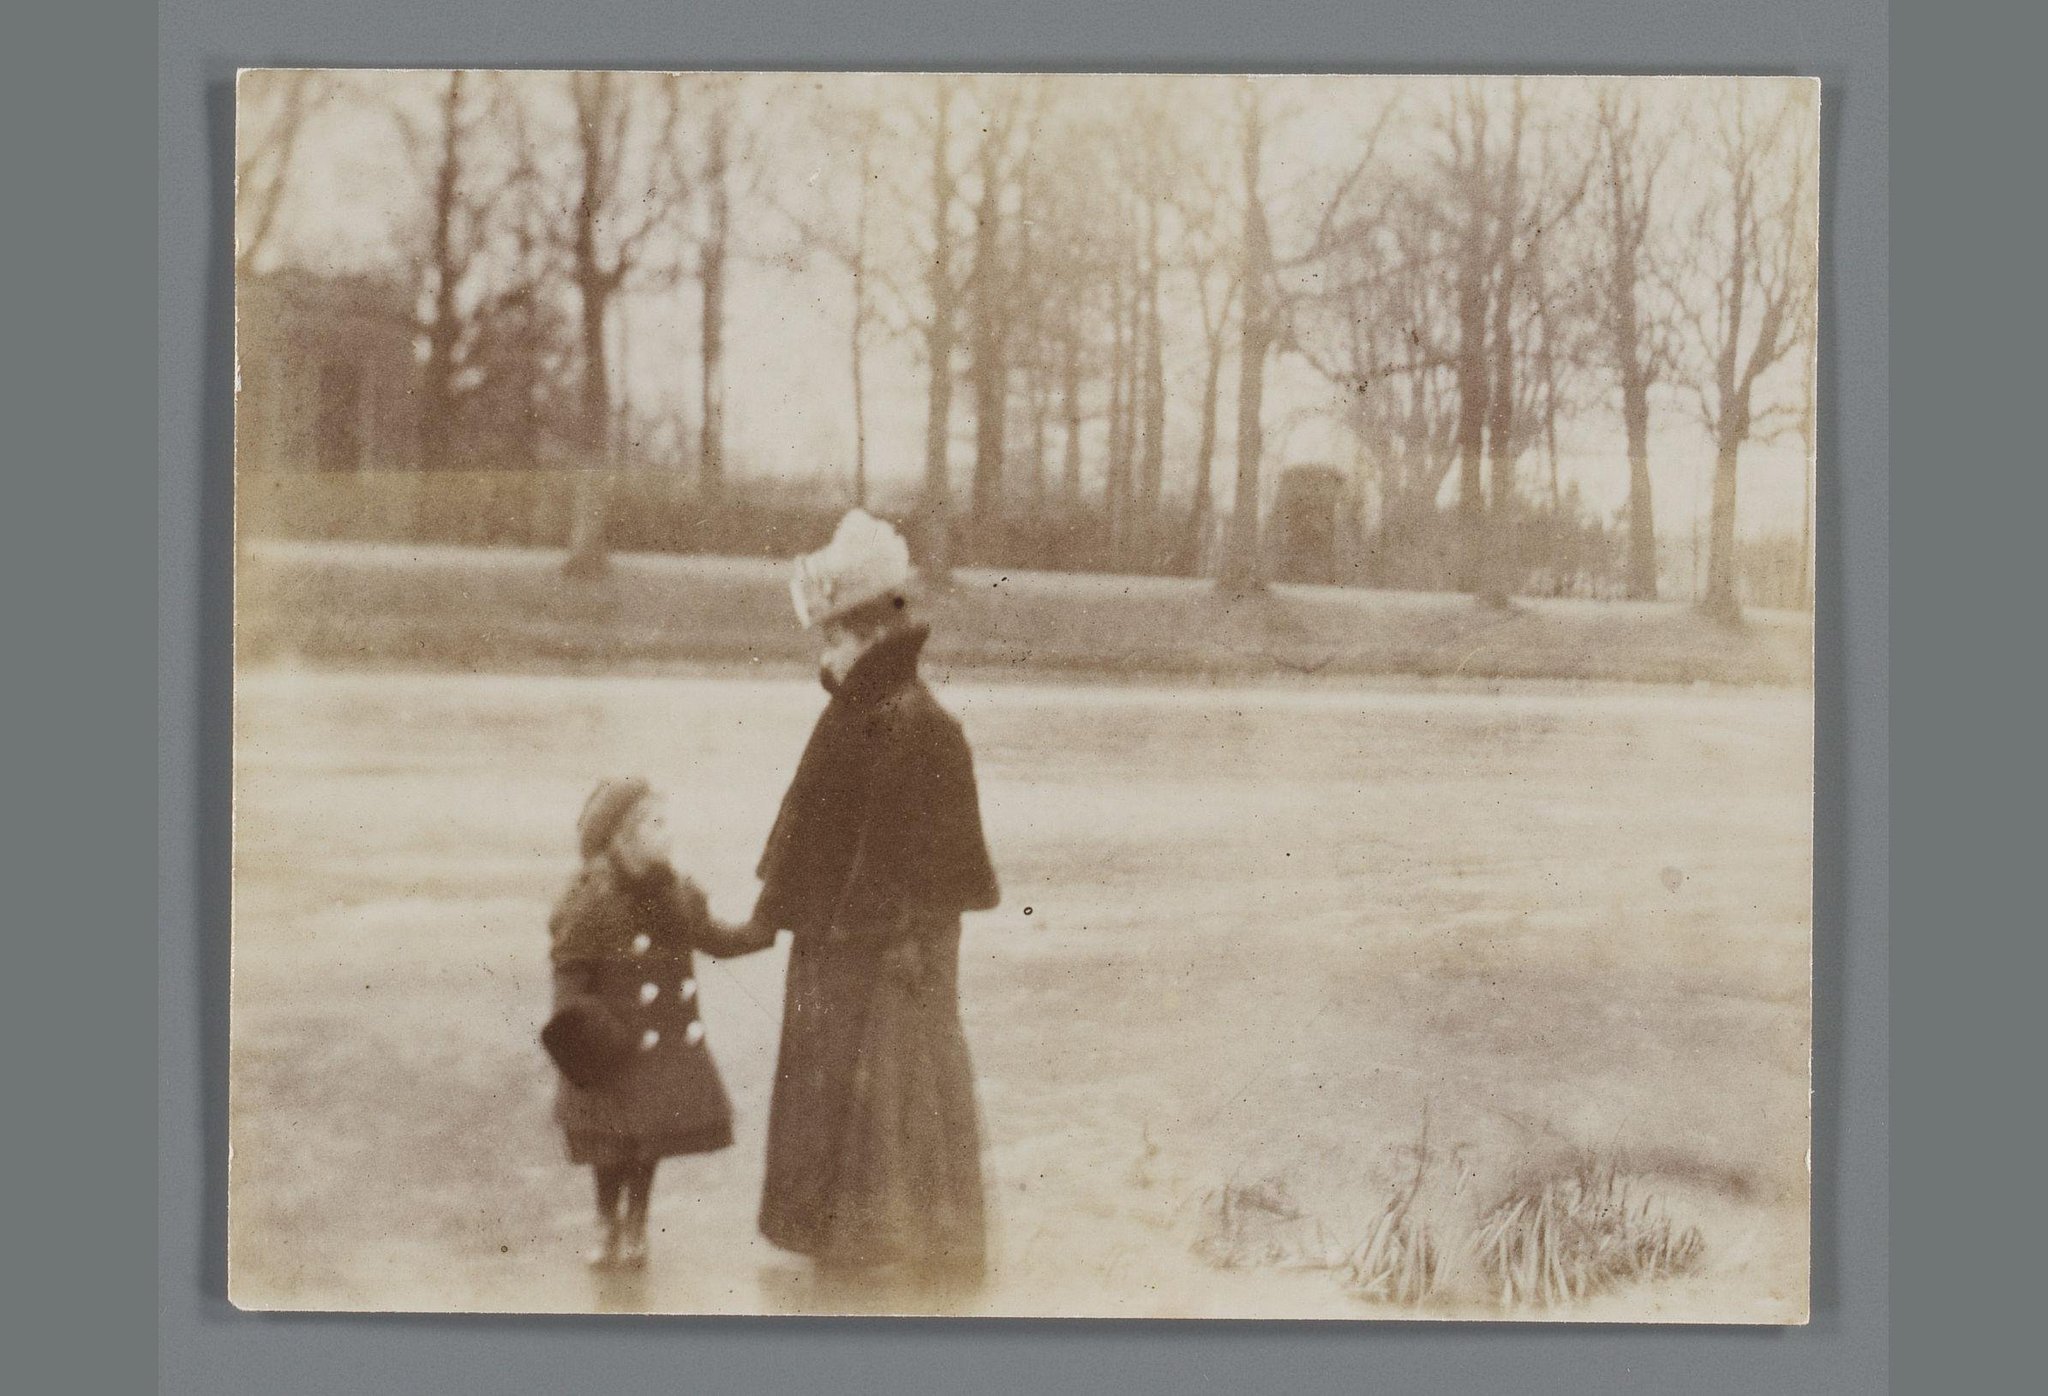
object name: photograph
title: Johanna (Hans) de Jong met haar stiefmoeder Elisabeth de Jong op natuurijs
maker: willem de jong (fotograaf)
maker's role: arts, fotograaf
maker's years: 1864-1918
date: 1900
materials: paper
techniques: collodion silver print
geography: netherlands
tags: haarlem, elisabeth de jong-van tonderen, leiden, johanna petronella lambertina stokhuyzen-de jong (hans), historical persons, girl (child between toddler and youth), ice ~ freezing weather, netherlands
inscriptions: inscription: ‘Hansje met/ omietje Beppie’, inscription: ‘Witte Angel/ "hoenhoven"-koepeltje’, inscription: ‘[...] 1/81’